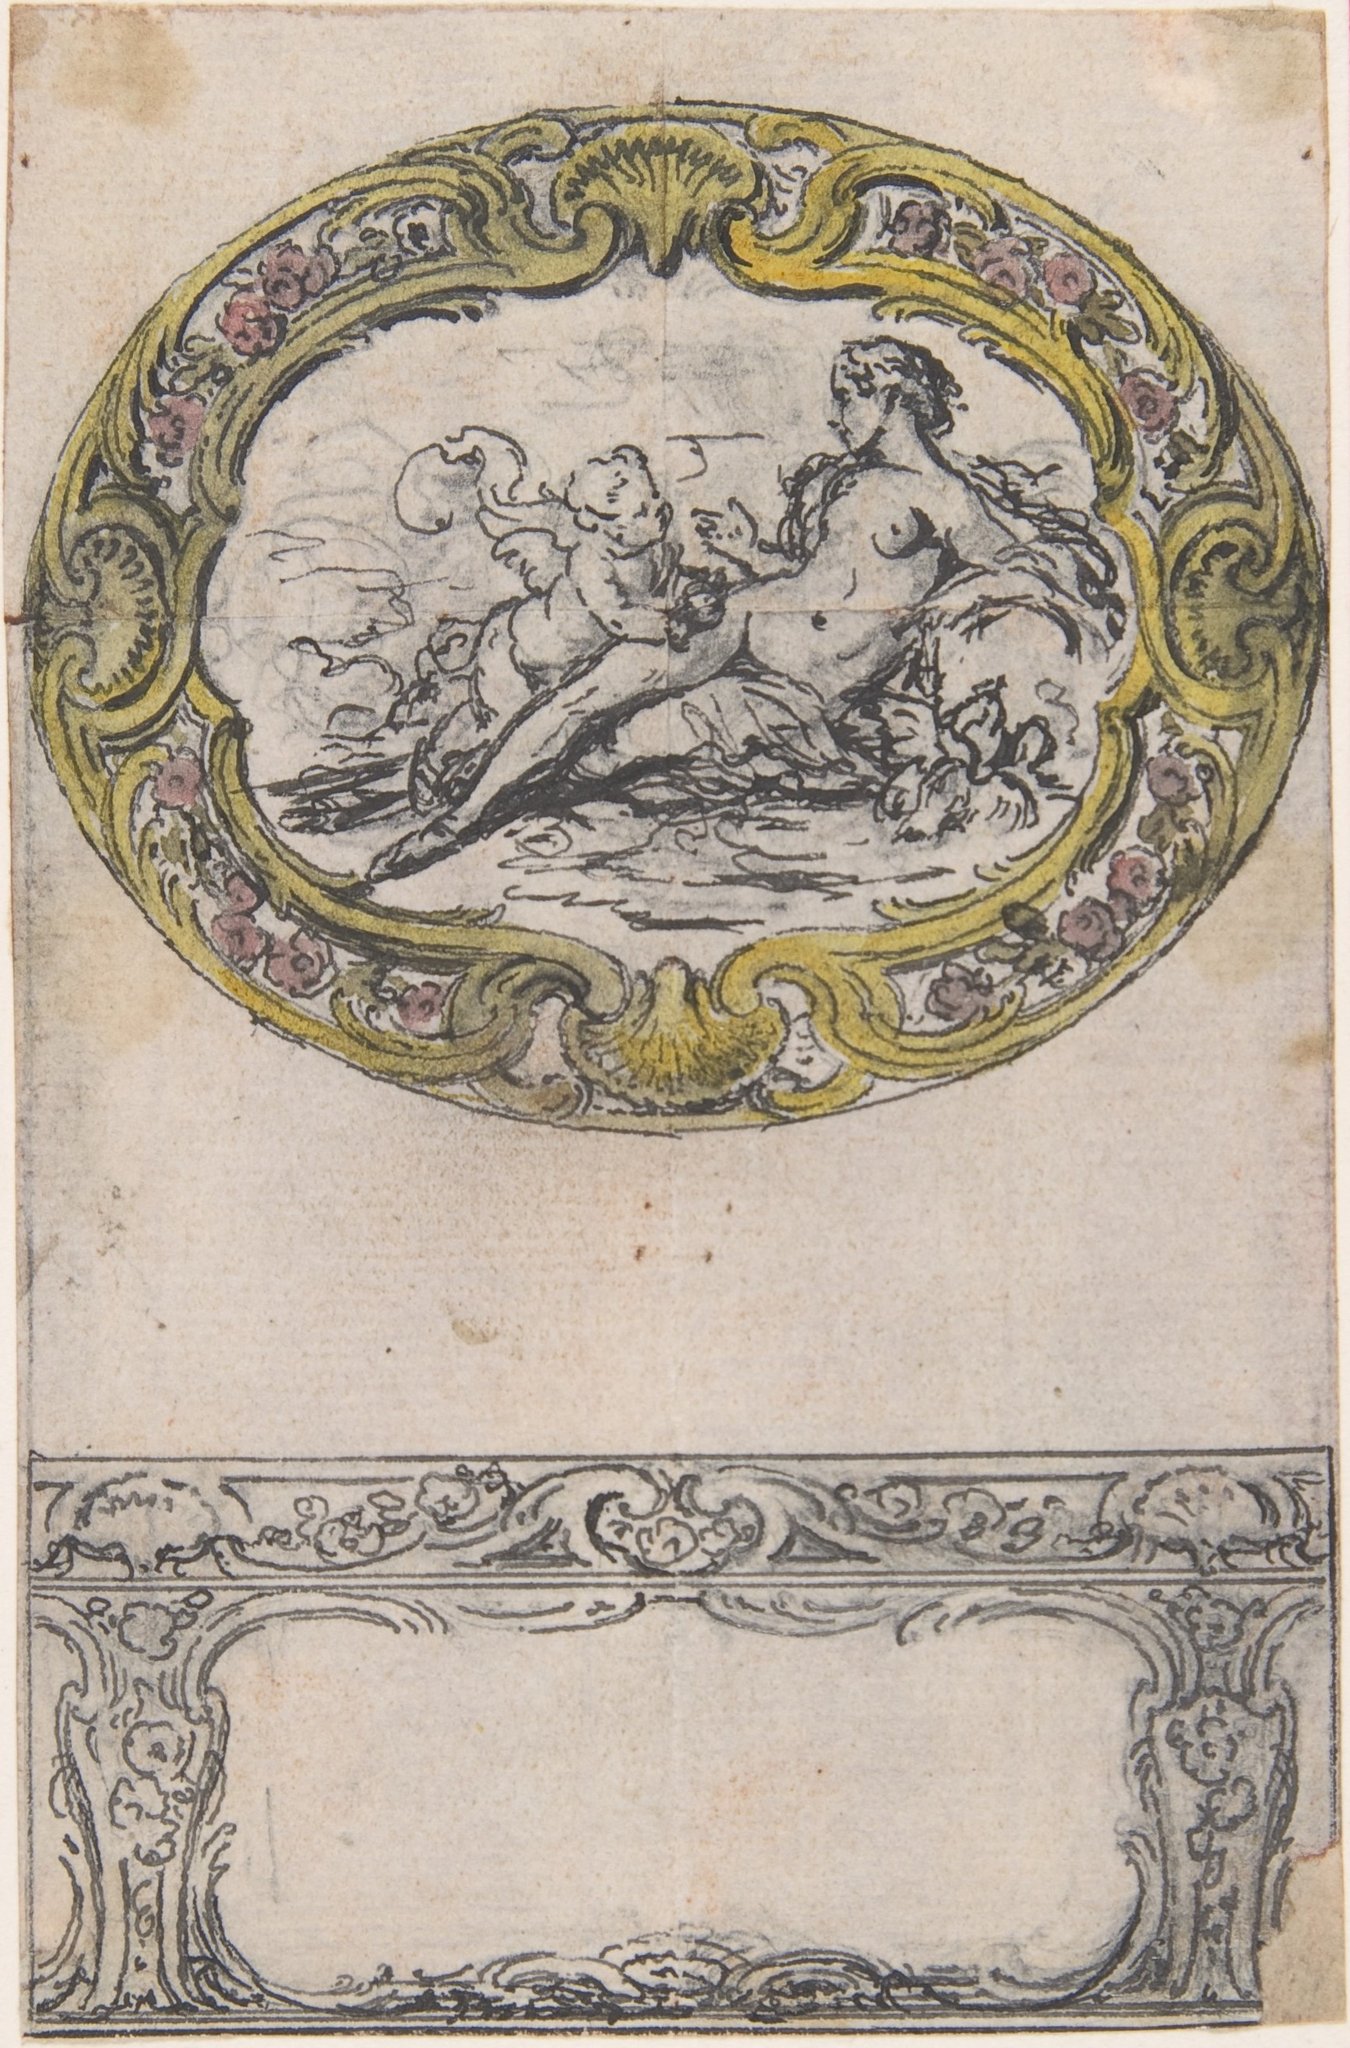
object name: drawing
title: Design for an Oval Gold Box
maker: hubert françois gravelot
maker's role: artist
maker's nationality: french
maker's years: 1699-1773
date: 1699-1773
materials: graphite, ink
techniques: brush, pen, wash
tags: female nudes